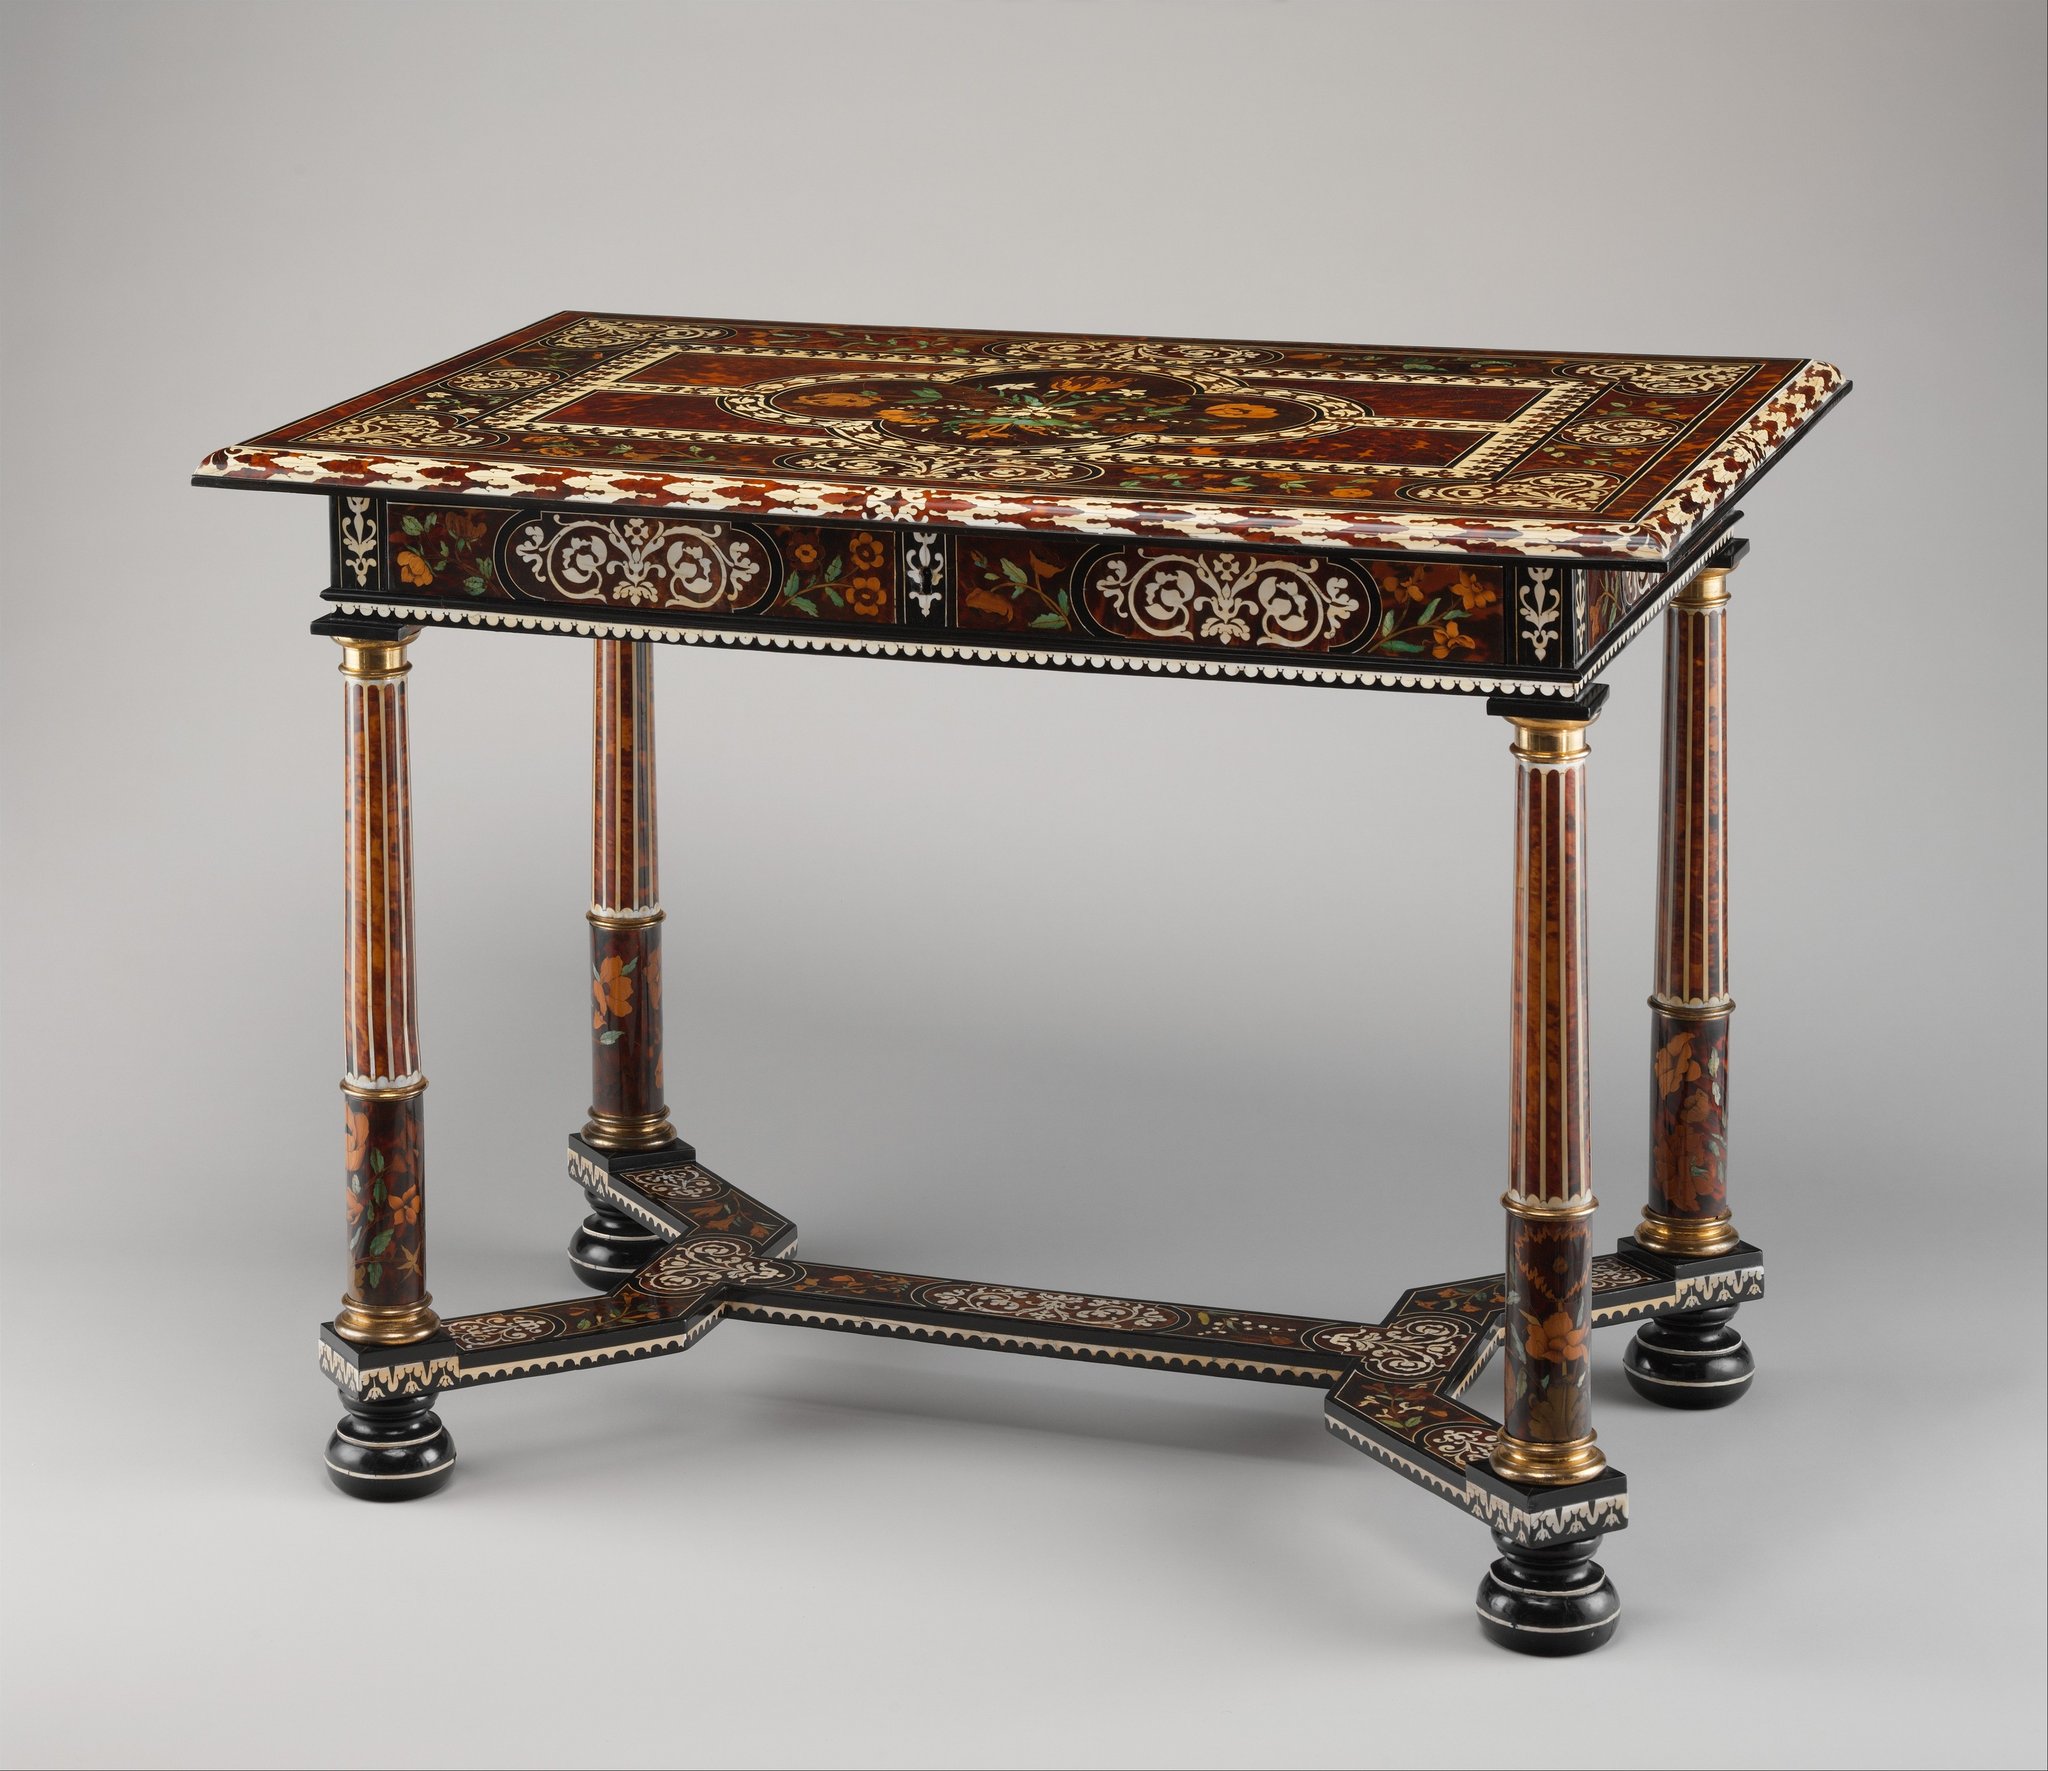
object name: table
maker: pierre gole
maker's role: maker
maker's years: 1620-1684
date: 1660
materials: wood, gilt bronze, ivory, shell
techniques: stain, veneering